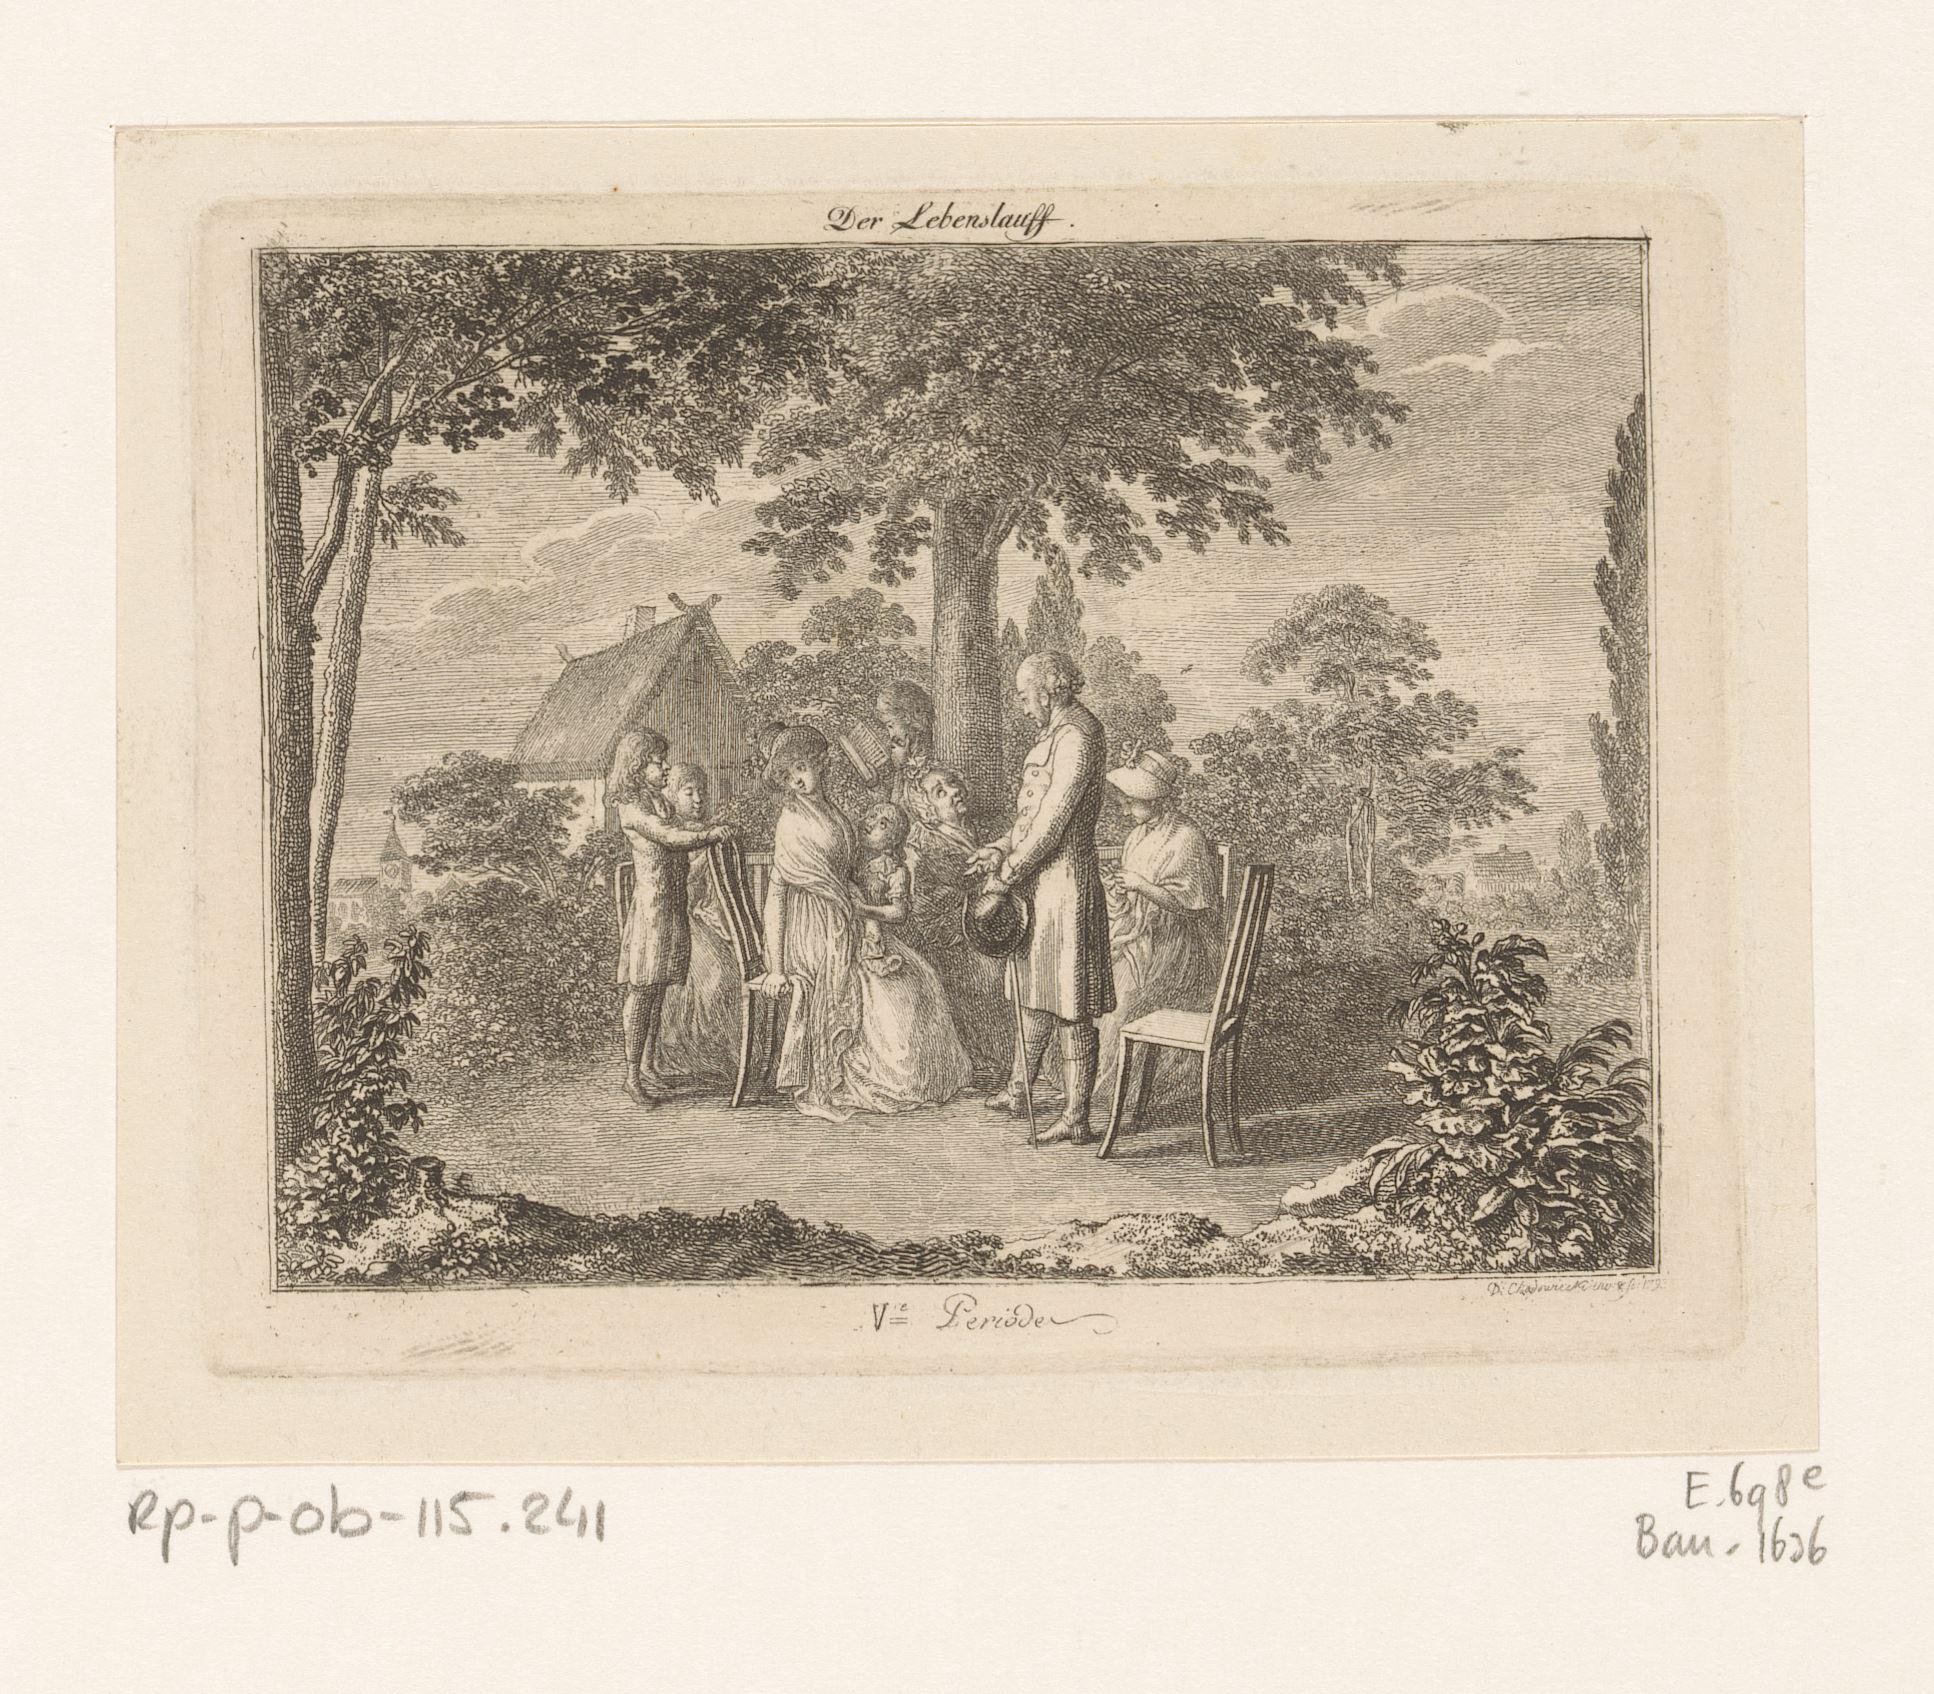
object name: print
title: Der Lebenslauf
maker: daniel nikolaus chodowiecki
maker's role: draughtsman, print maker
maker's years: 1726-1801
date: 1793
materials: paper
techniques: etching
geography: berlin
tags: bench, child, old man, family, relationship, descent, farm or solitary house in landscape, the life of man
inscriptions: collector's mark: Lugt 2228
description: Onderdeel van een serie van acht prenten over de levensloop van de mens.